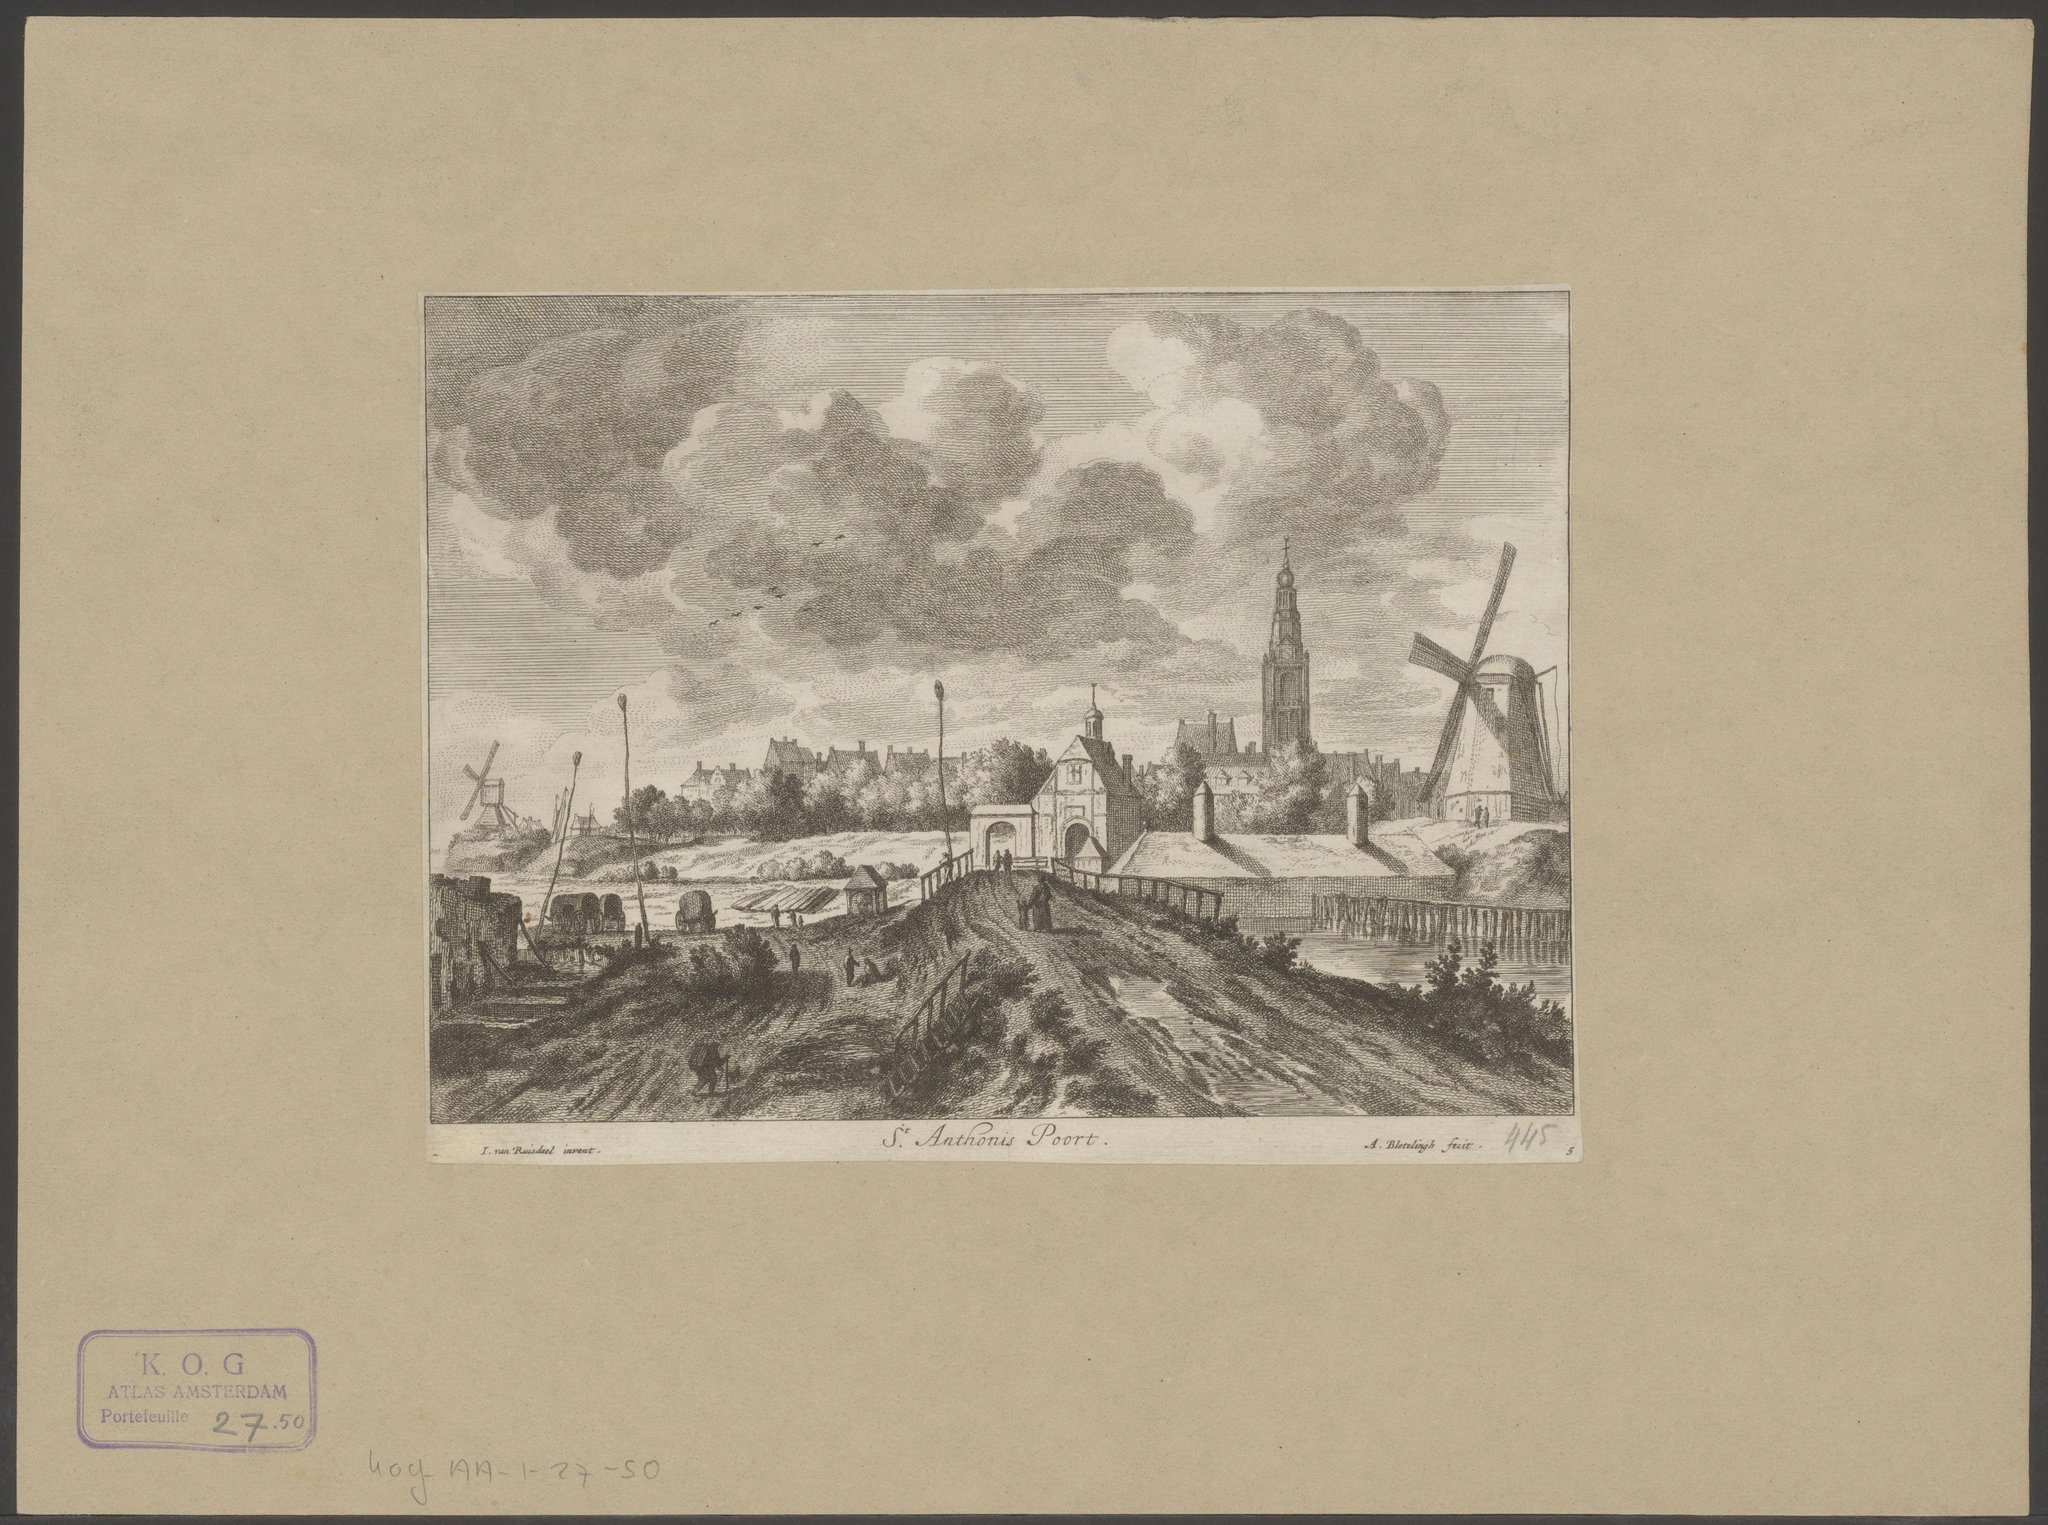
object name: print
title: Gezicht op de Eerste Sint-Antoniespoort te Amsterdam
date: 1655-1690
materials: paper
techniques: engraving, etching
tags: windmill in landscape, city-gate, parts of church exterior and annexes: tower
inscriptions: collector's mark: Lugt 1641b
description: Rechtsonder genummerd: 5. Onderwerpsrubriek binnen de Atlas Amsterdam: Poorten, verzamelbladen, C. St. Antoniespoort.